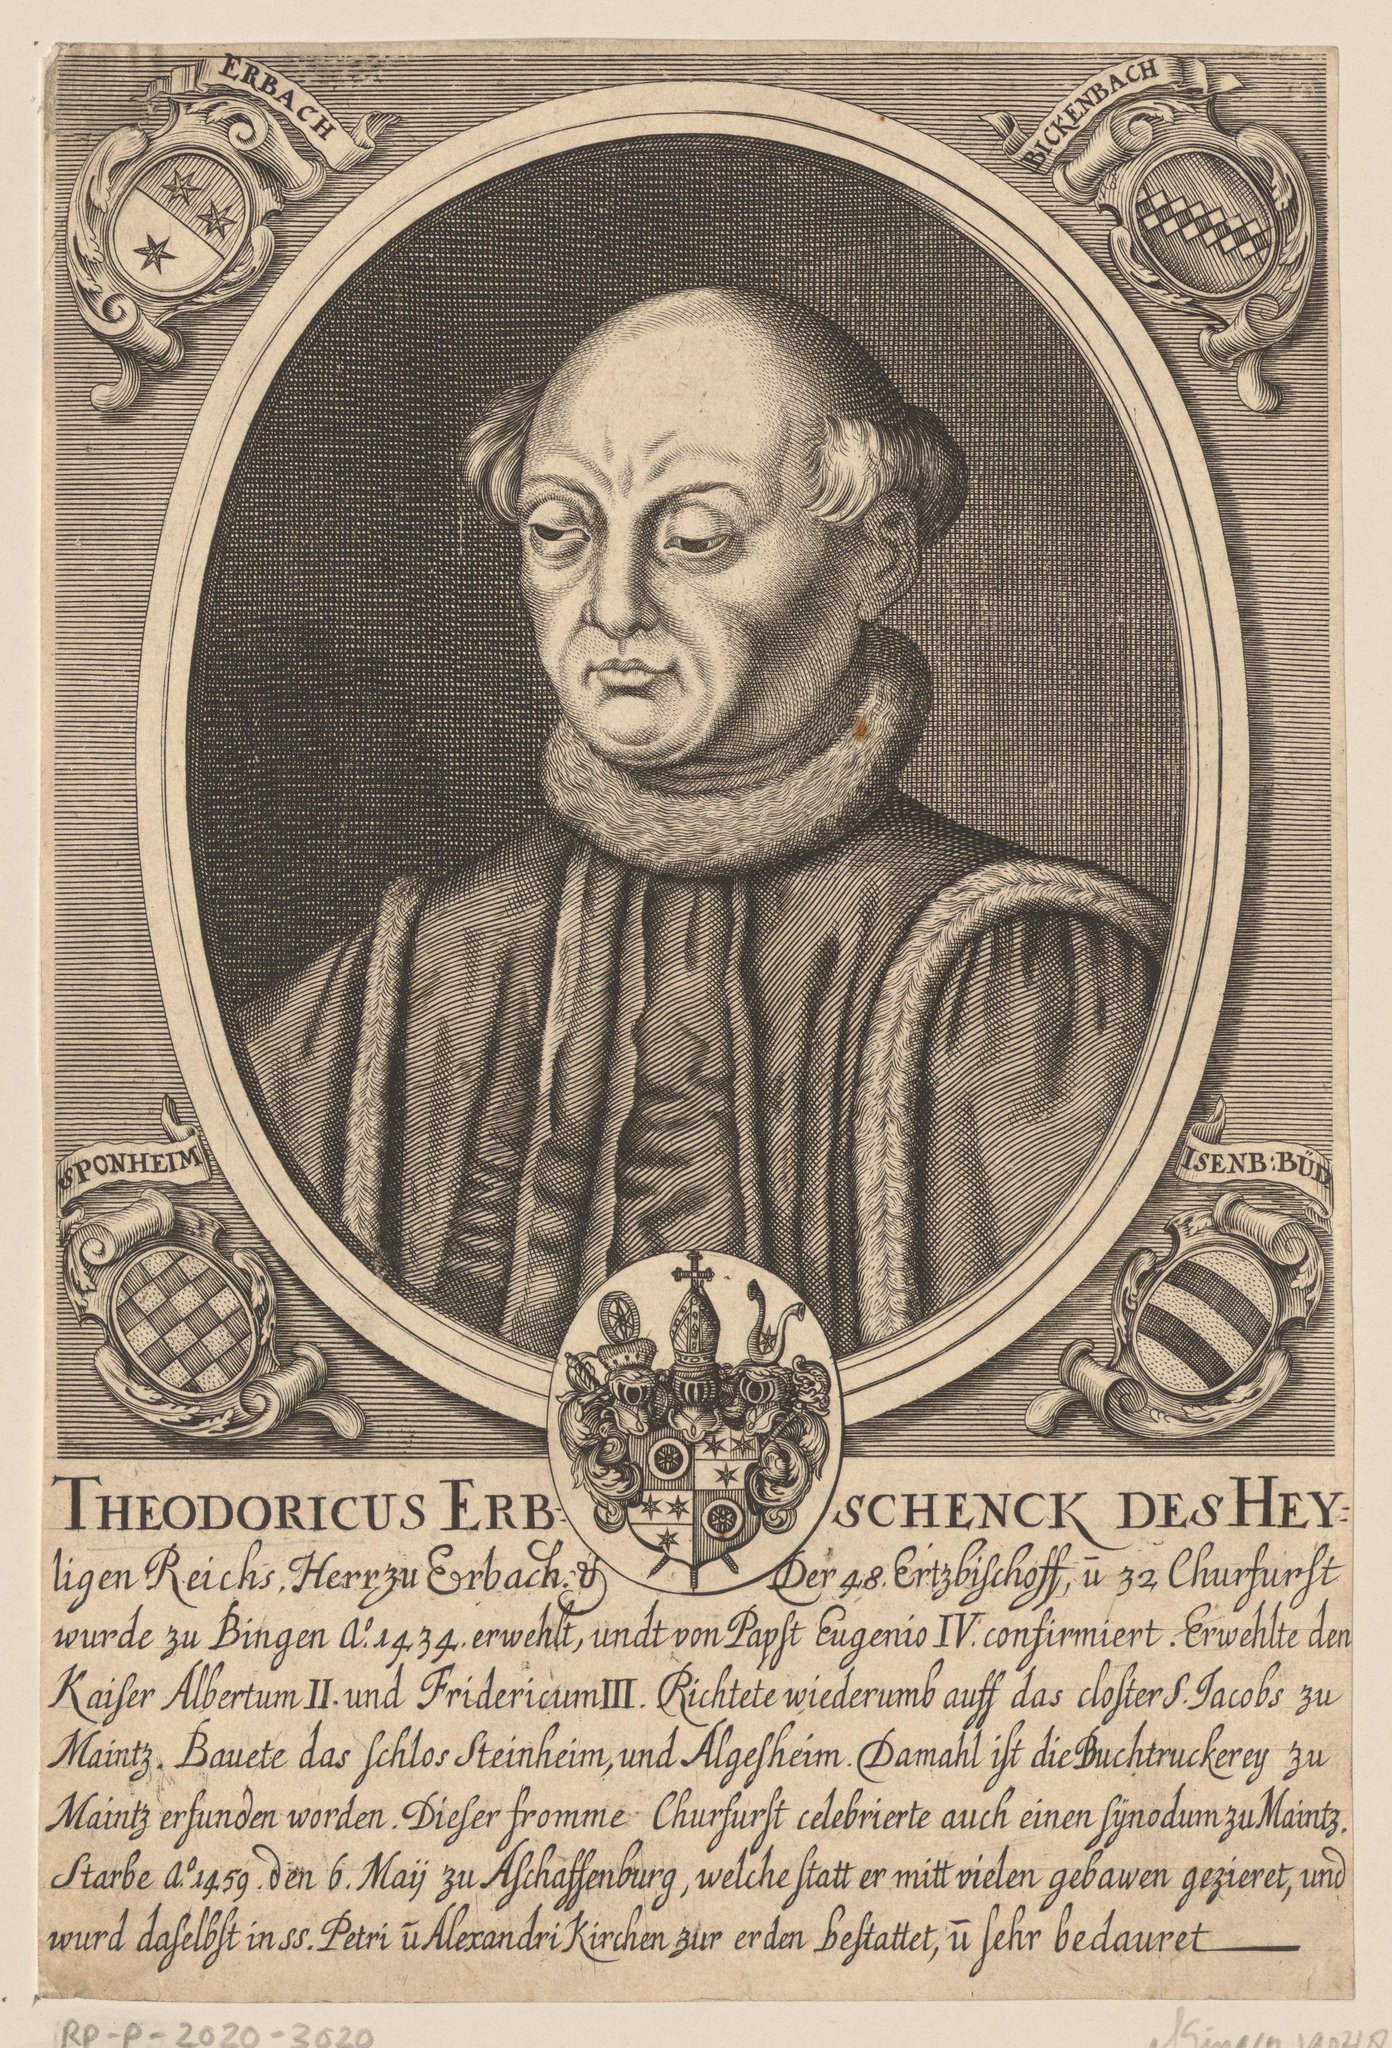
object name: print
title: Portret van Dietrich Schenk von Erbach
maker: Anonymous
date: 1600-1650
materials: paper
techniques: engraving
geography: germany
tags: archbishop, bishop, etc. (roman catholic), historical persons, armorial bearing, heraldry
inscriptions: inscription: ‘No 4152/ 2s’, collector's mark: Lugt 2233